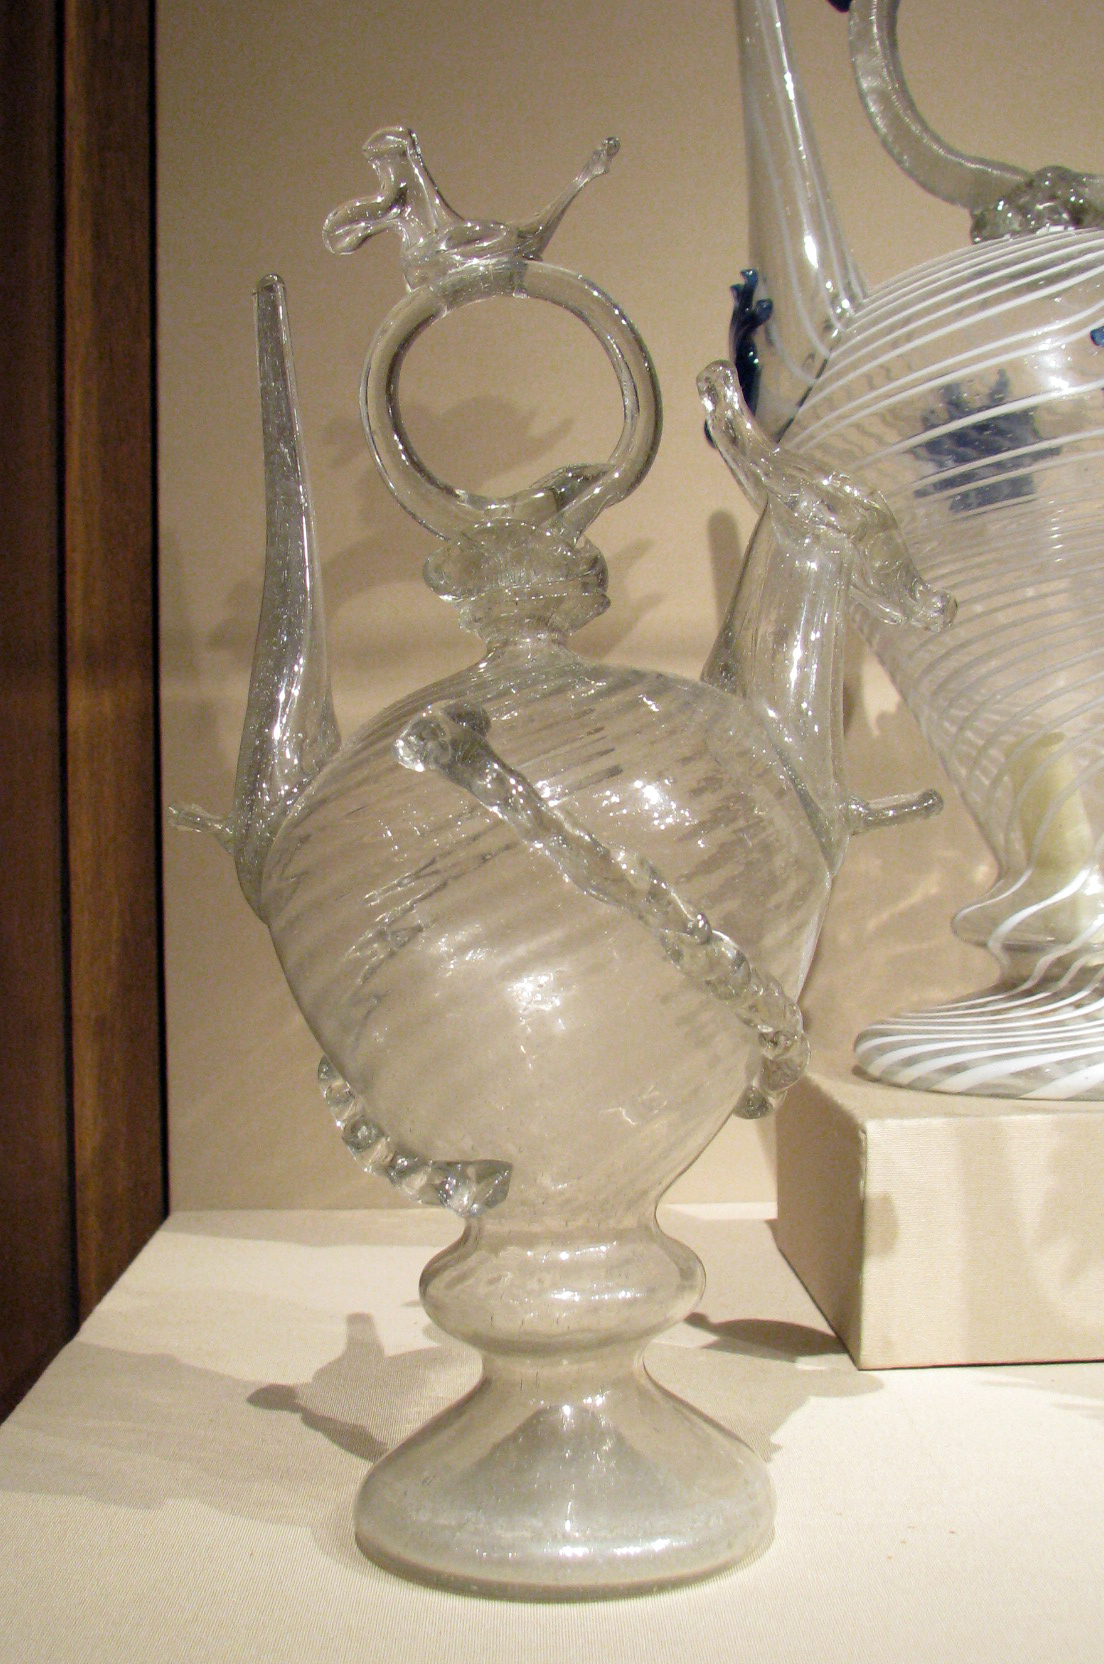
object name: water vessel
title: Water vessel (Càntir)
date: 1701-1800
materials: glass